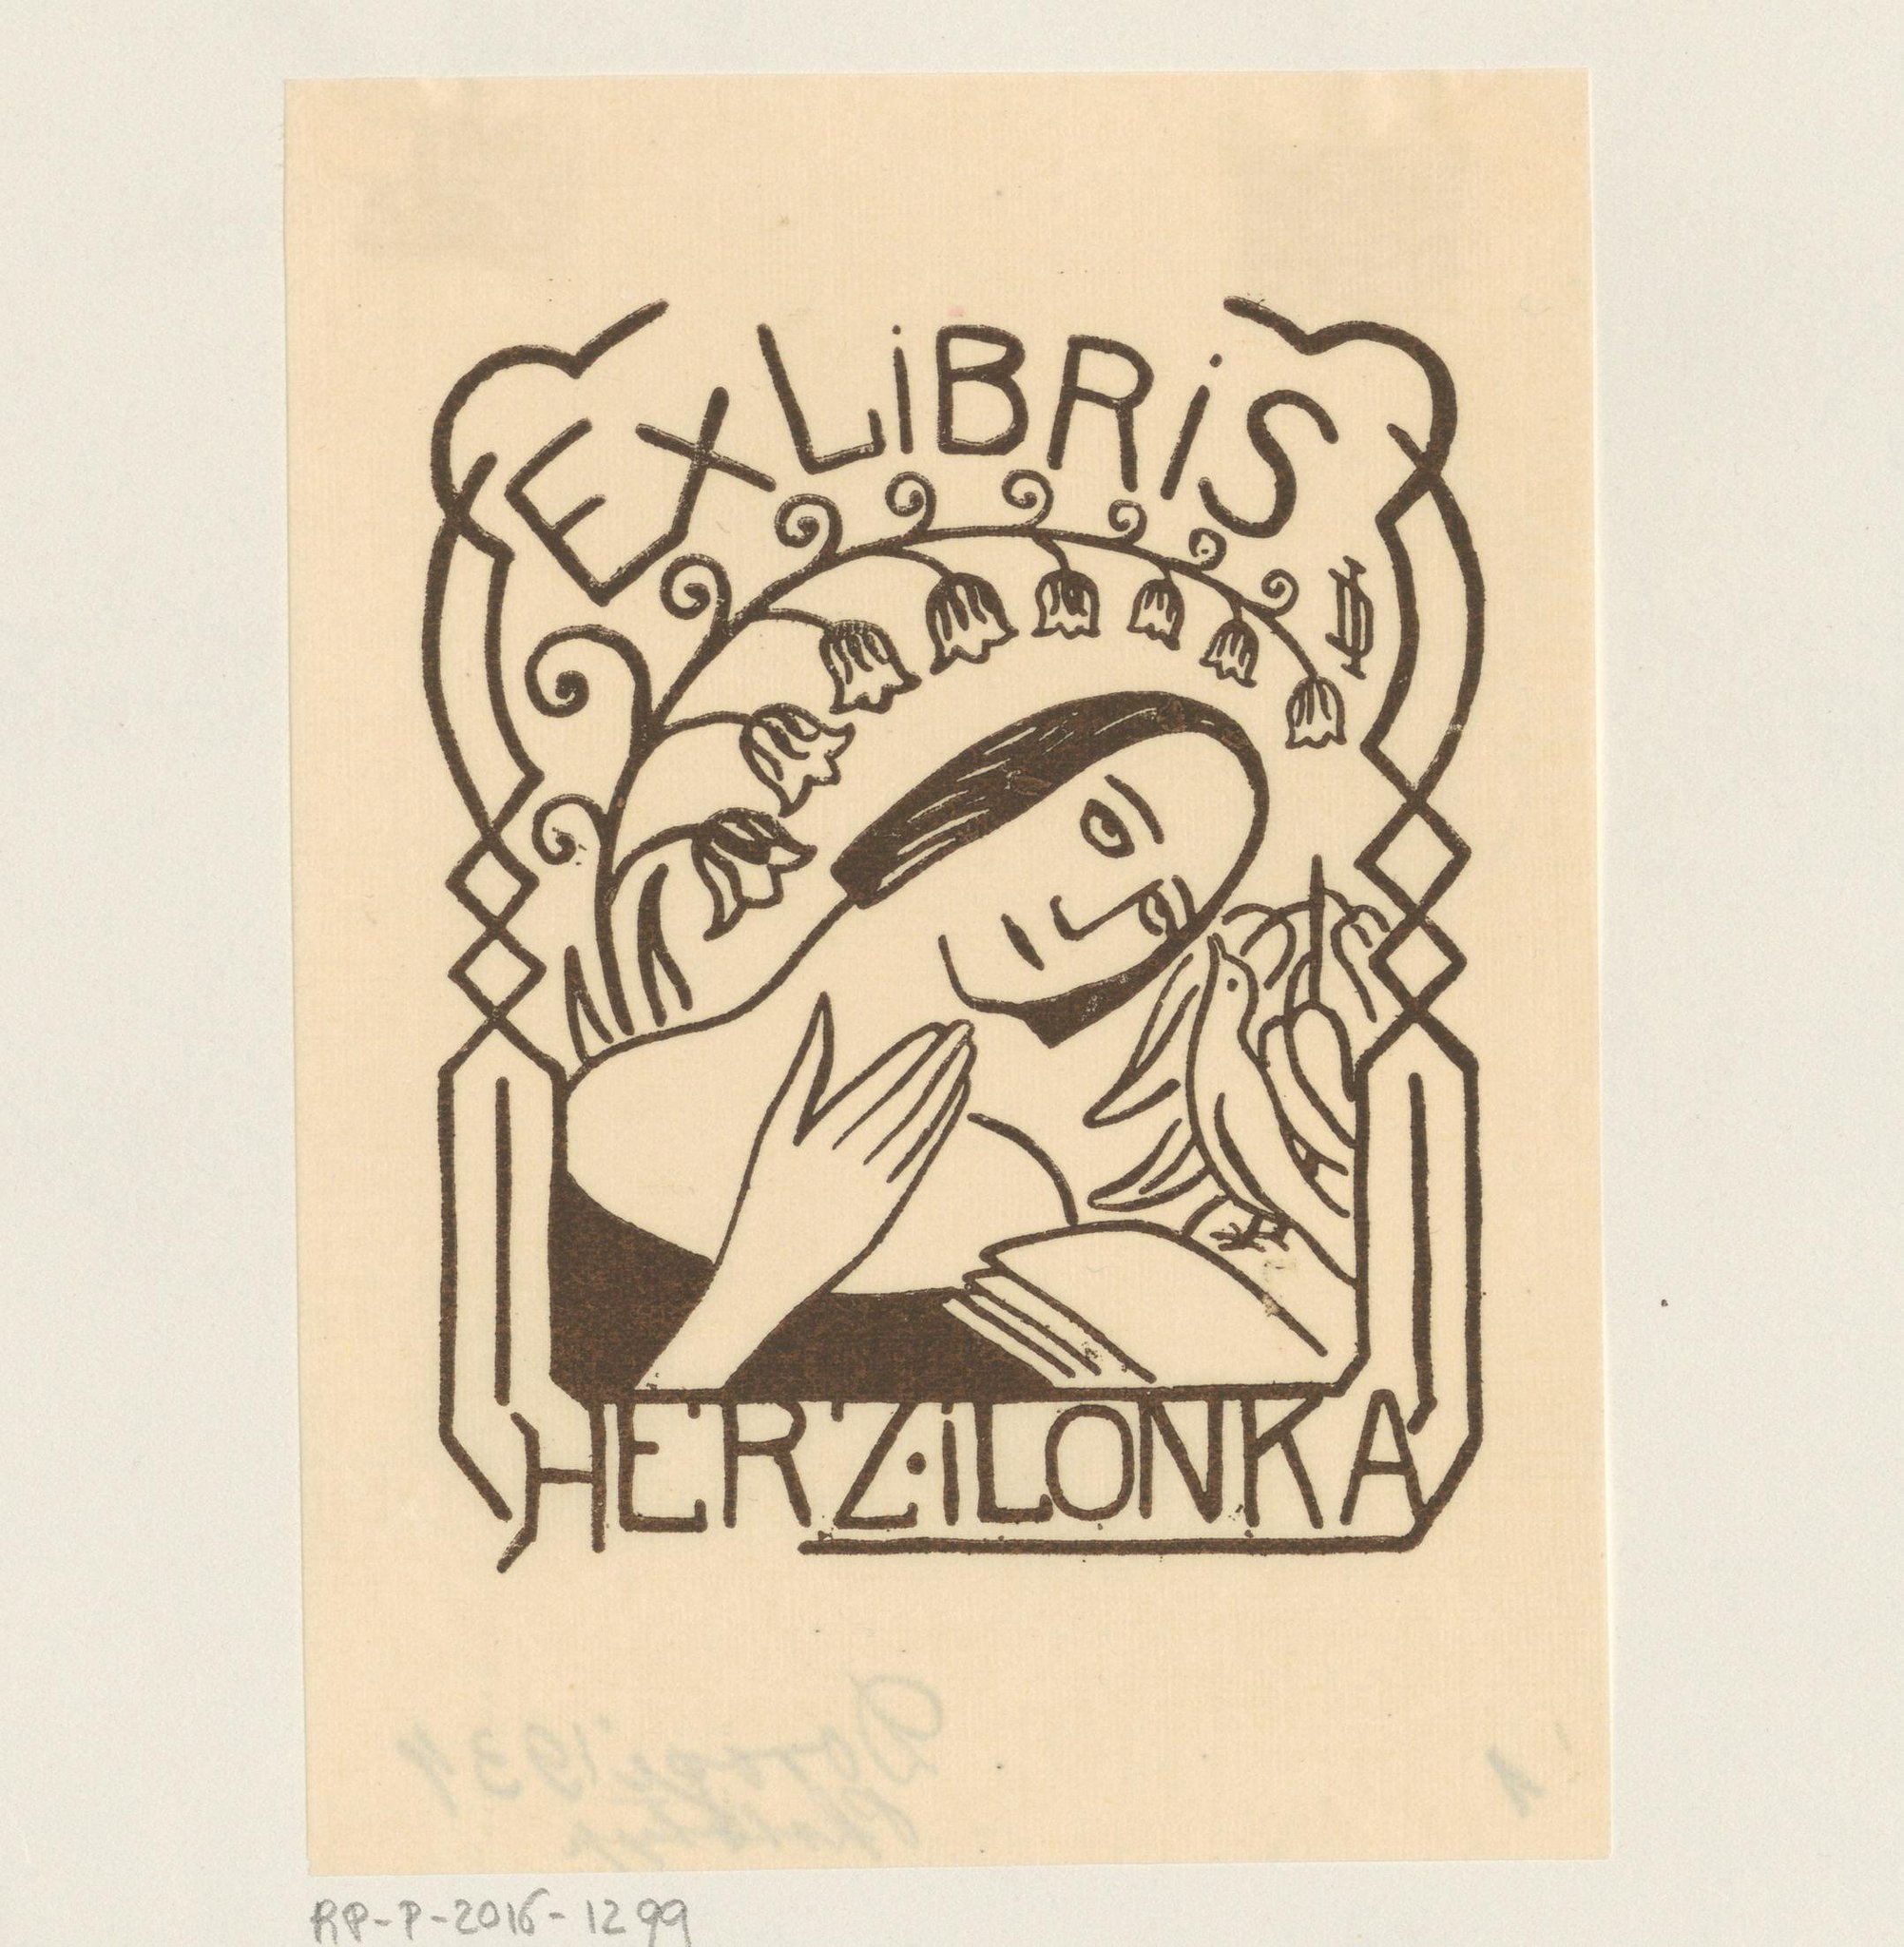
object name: bookplate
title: Ex libris van Herz Ilonka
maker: Anonymous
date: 1934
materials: paper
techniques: printing block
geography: hungary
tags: flowers, adult woman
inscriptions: monogram: ‘ID’, inscription: ‘1 / Dorogi 1934 / Phototyp’